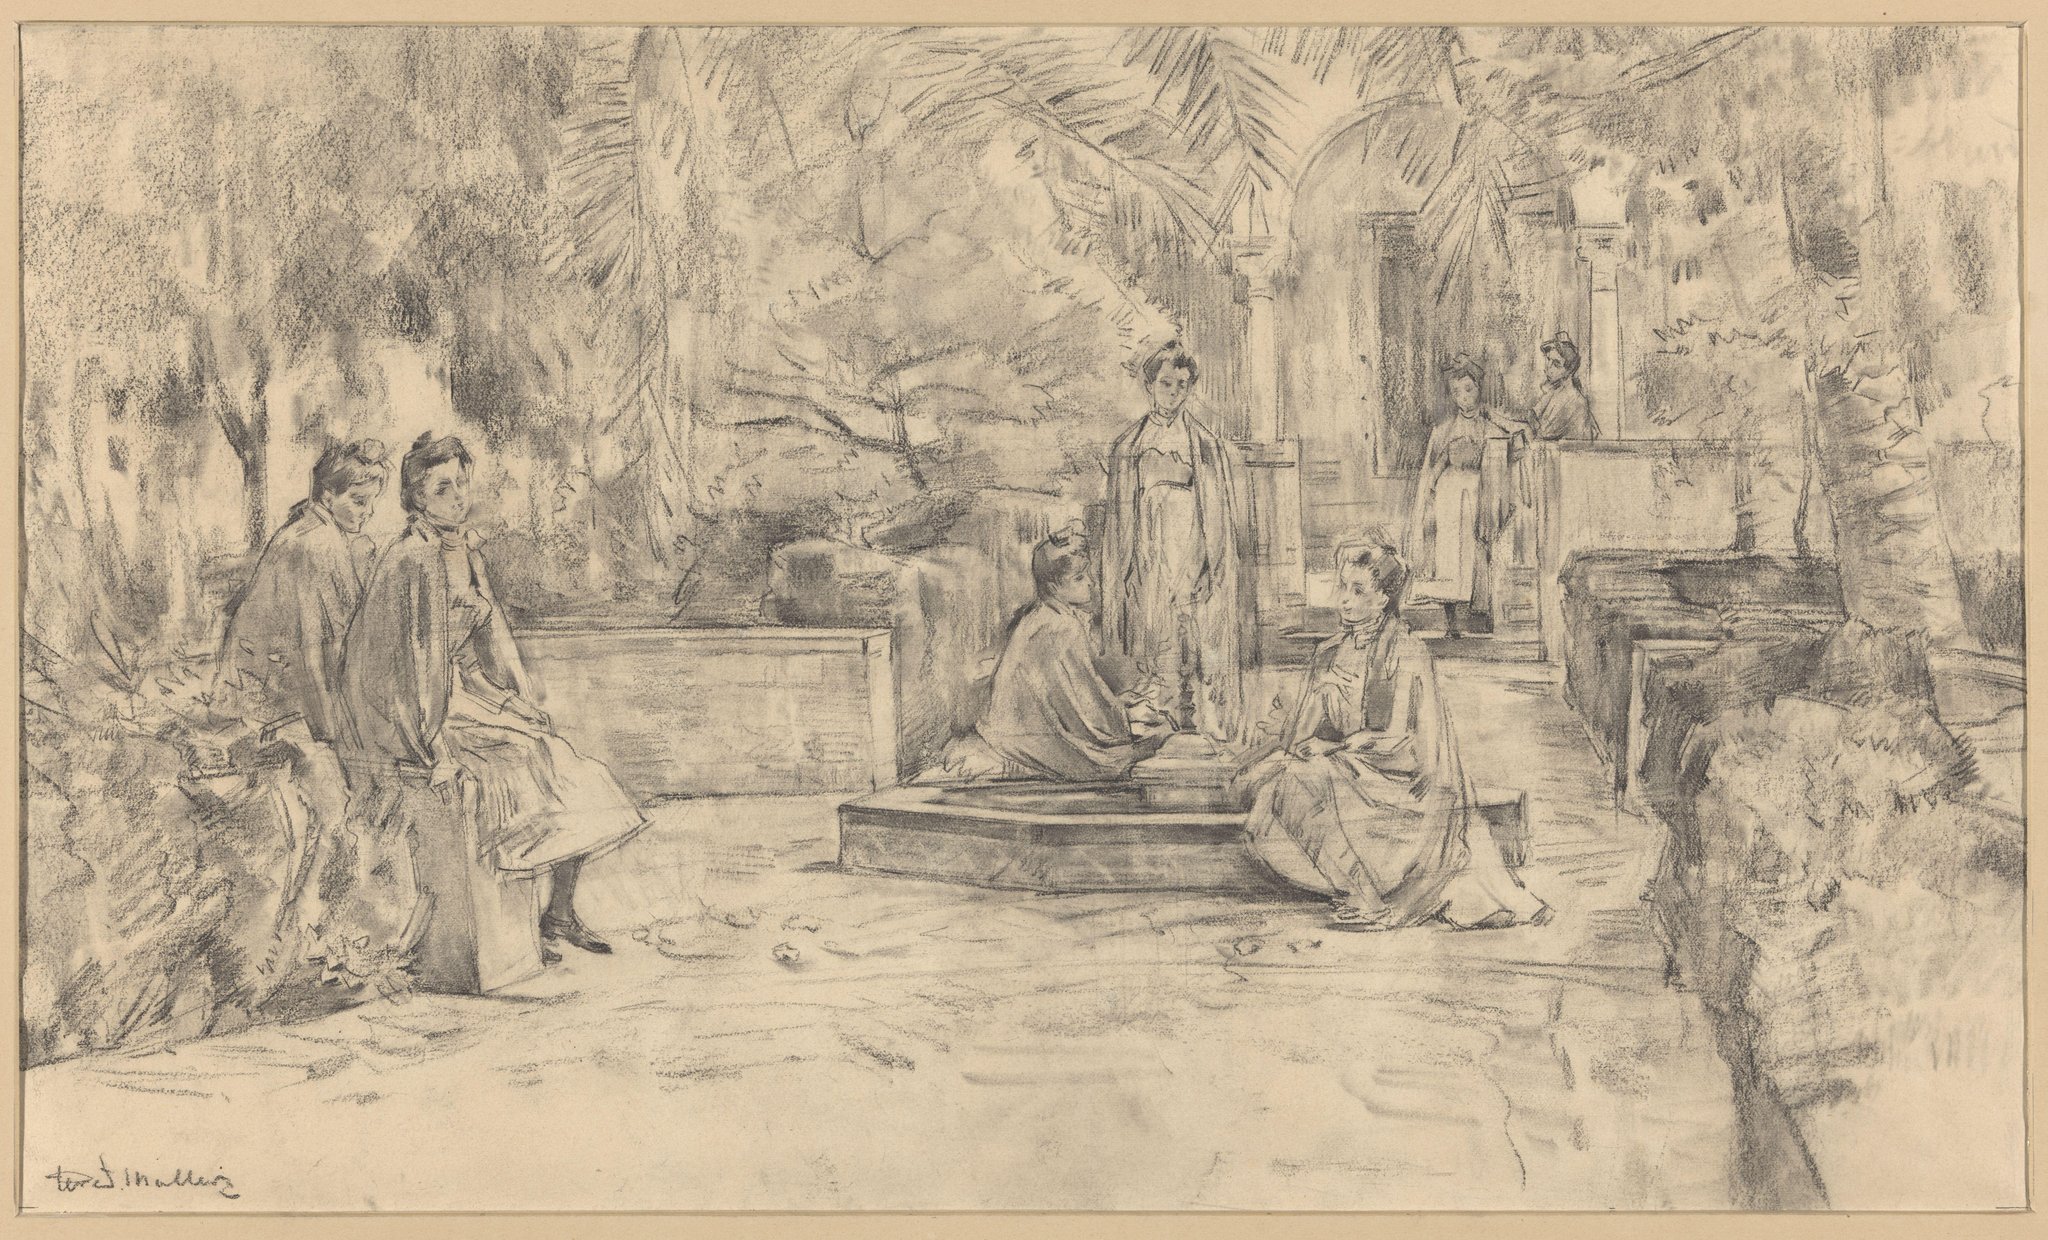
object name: drawing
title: Fontein bij het paviljoen van Karel V in het Koninklijk Paleis te Sevilla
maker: gerard muller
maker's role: draughtsman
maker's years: 1861-1929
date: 1871-1903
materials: chalk, paper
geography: sevilla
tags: palace, ornamental fountain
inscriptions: collector's mark: Lugt 2228, label: ‘20. Alcázar. Sevilla/ De fontein, een geliefkoosd plekje.’